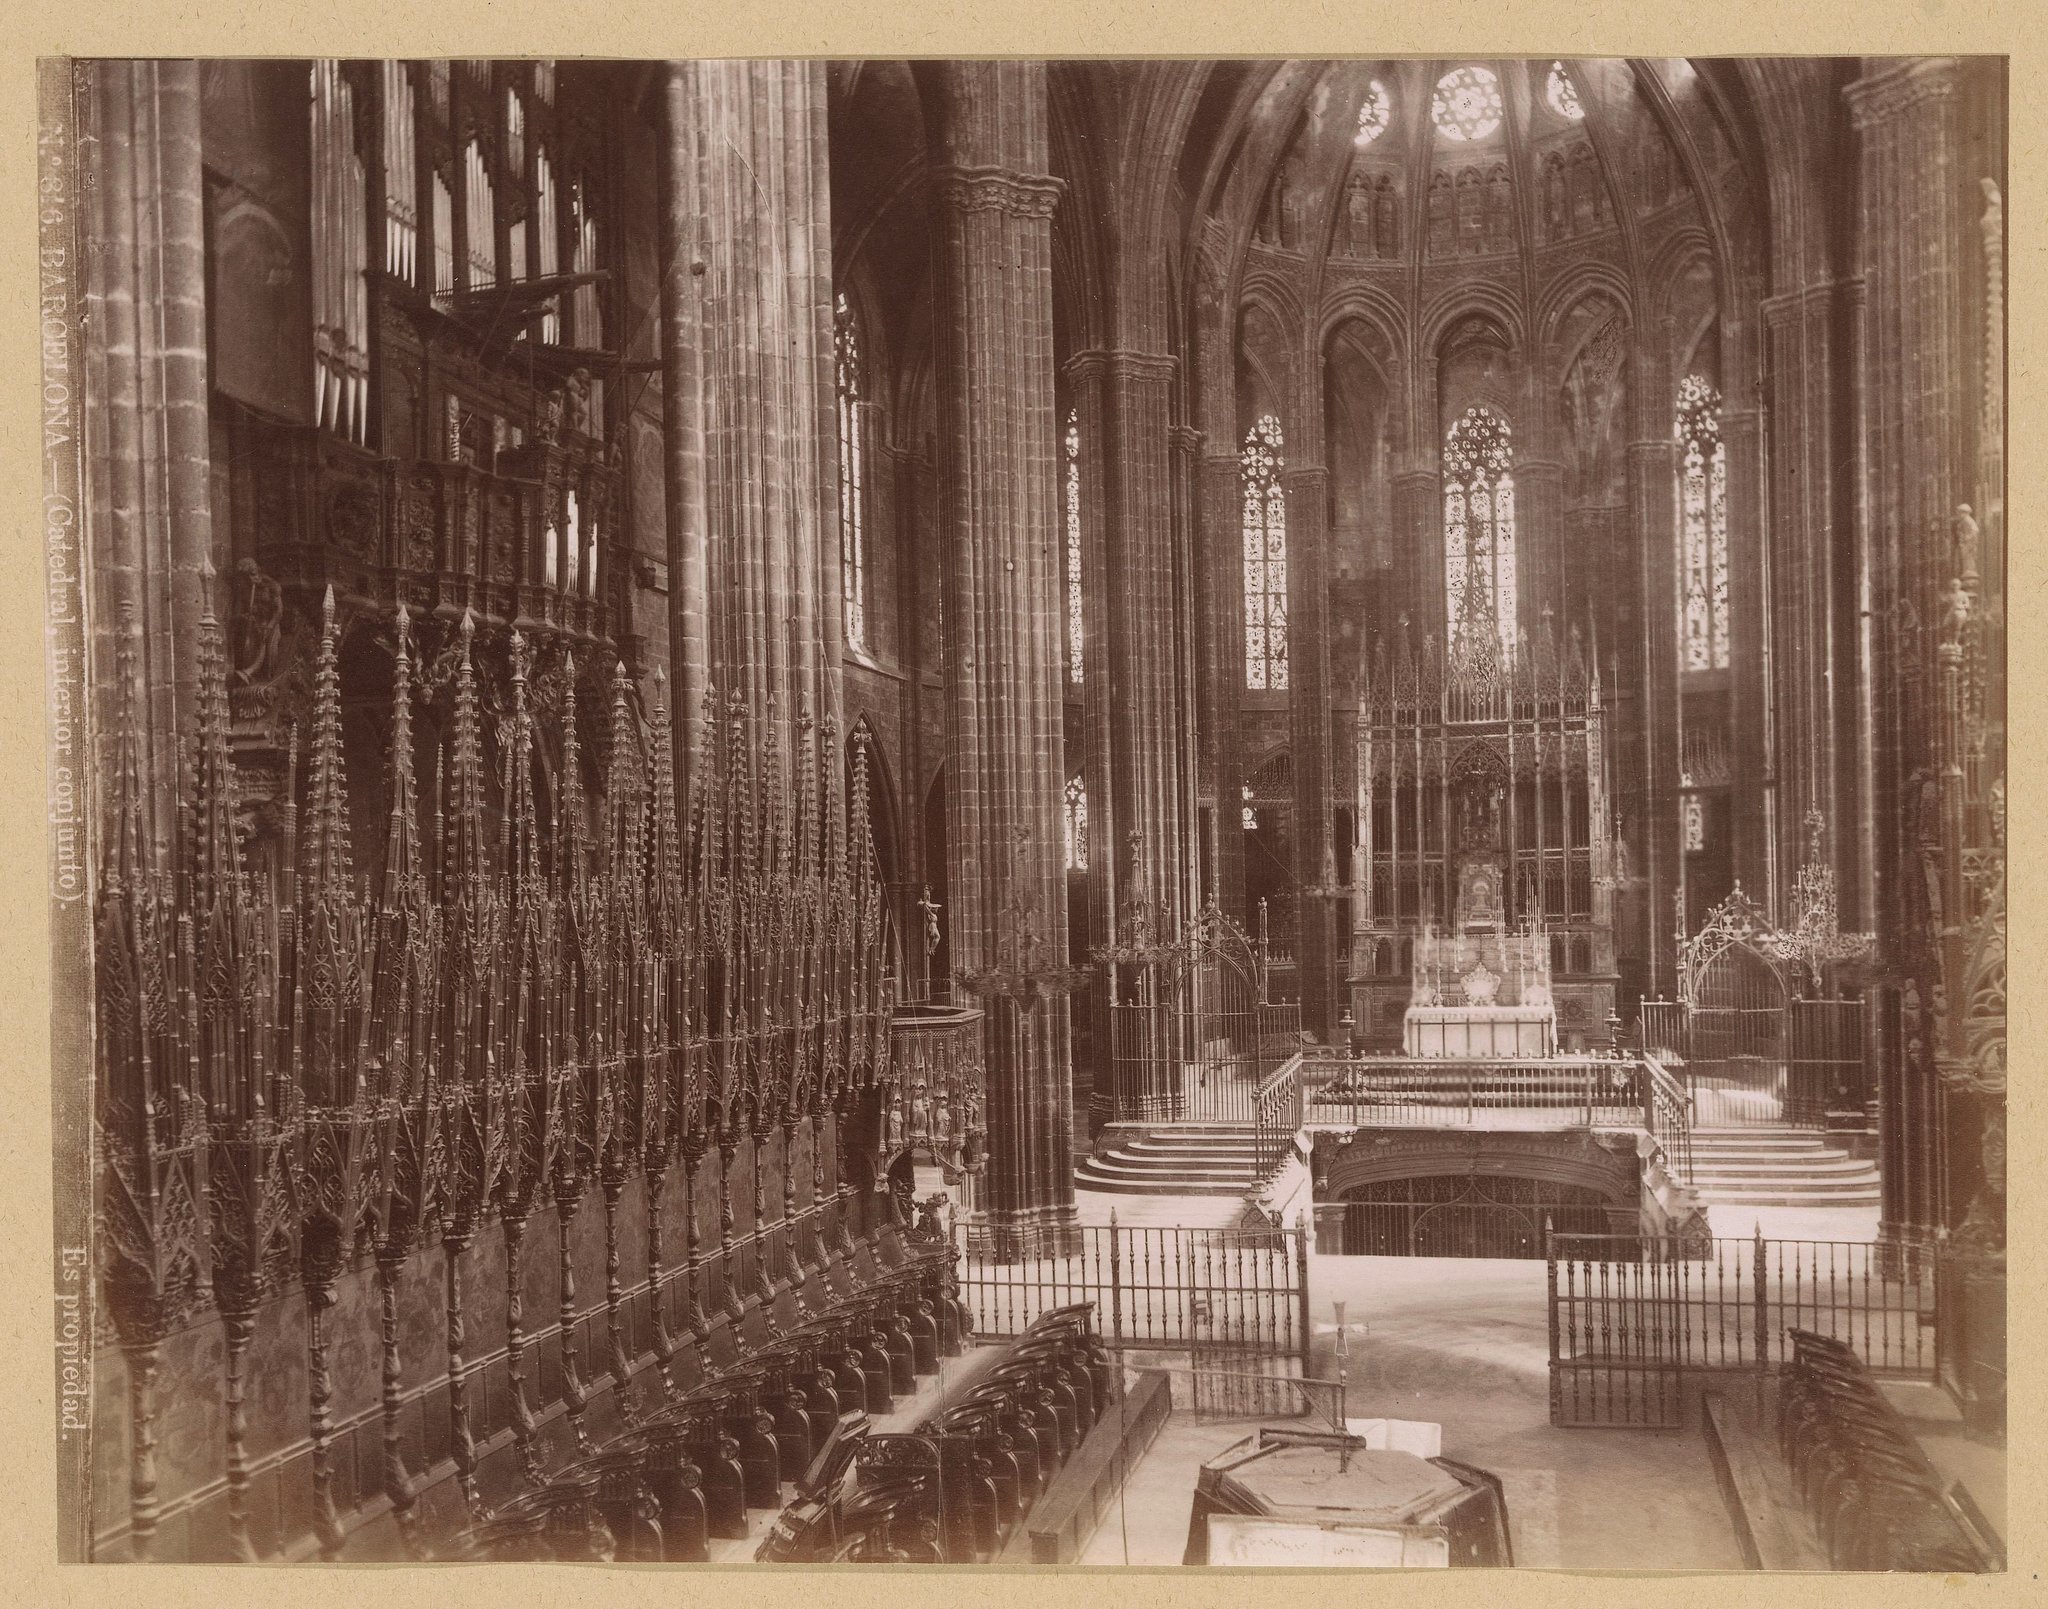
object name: photograph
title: Uitzicht vanaf het koor op het schip van de kathedraal van het Heilig Kruis en Sint Eulalia in Barcelona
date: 1851-1890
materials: paper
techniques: albumen print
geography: barcelona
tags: parts of church interior: nave, parts of church interior: choir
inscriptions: number: ‘No 816.’, inscription: ‘Es propiedad.’